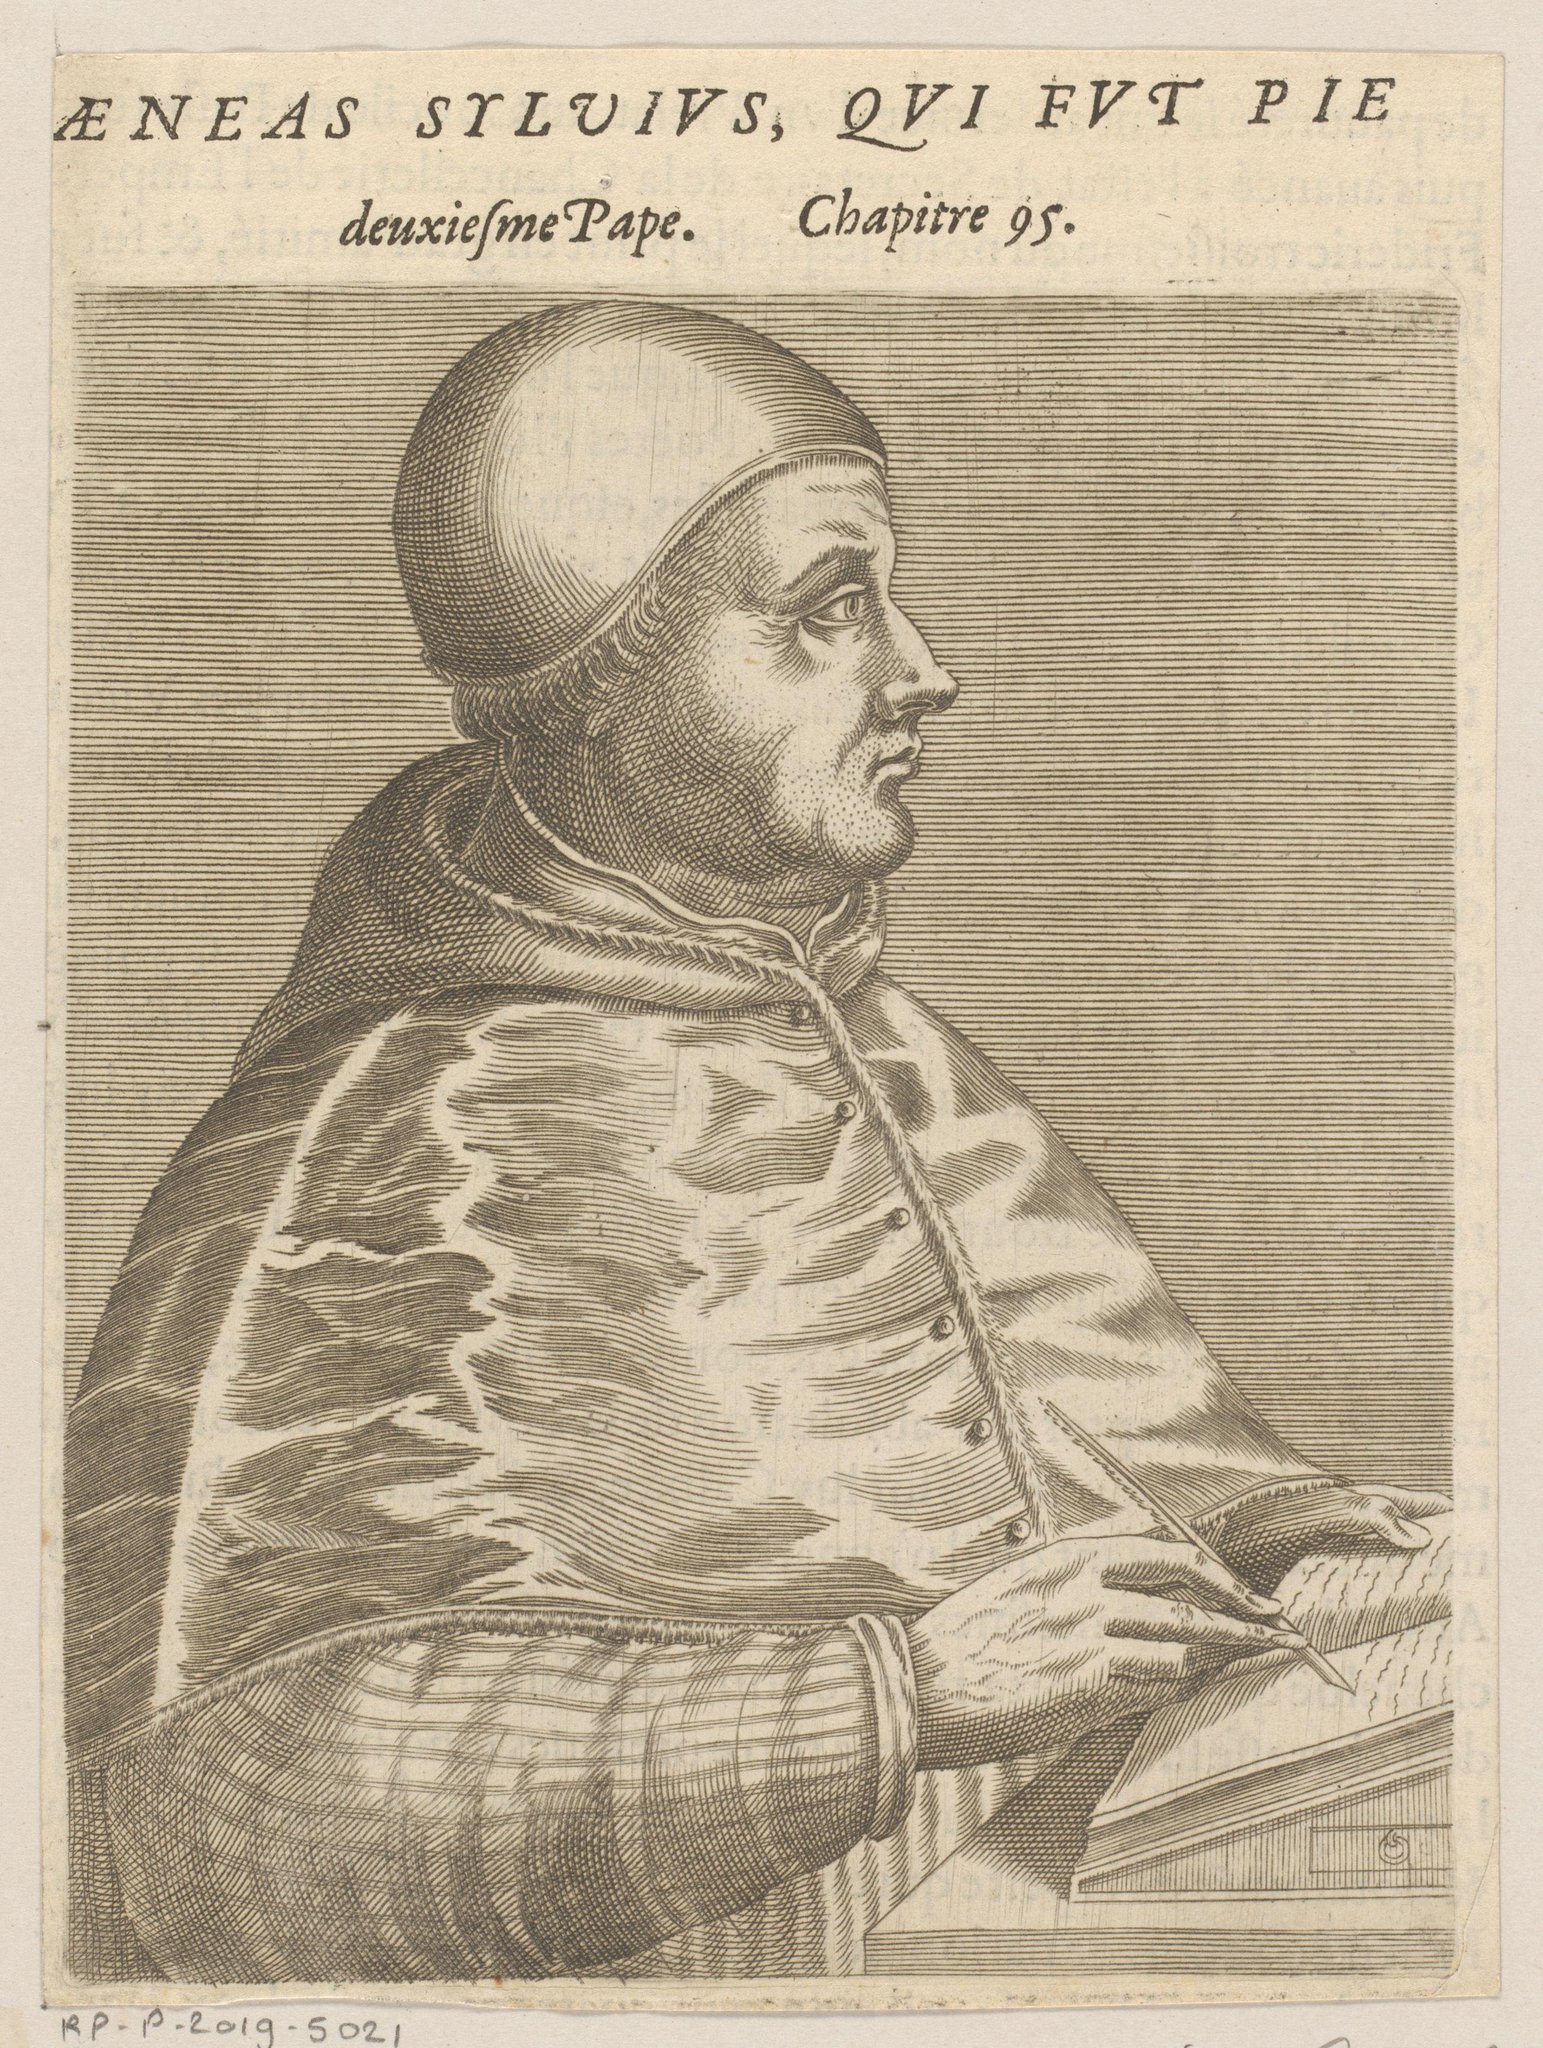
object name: print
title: Portret van paus Pius II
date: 1584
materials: paper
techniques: engraving, etching, letterpress printing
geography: paris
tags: rome, archbishop, bishop, etc. (roman catholic), historical persons, book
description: Prent uit: Thevet, André. Les vrais pourtraits et vies des hommes illustres grecz, latins et payens (...). Parijs: weduwe Jacques Kerver en Guillaume Chaudière, 1584, dl. 2, f. 510.